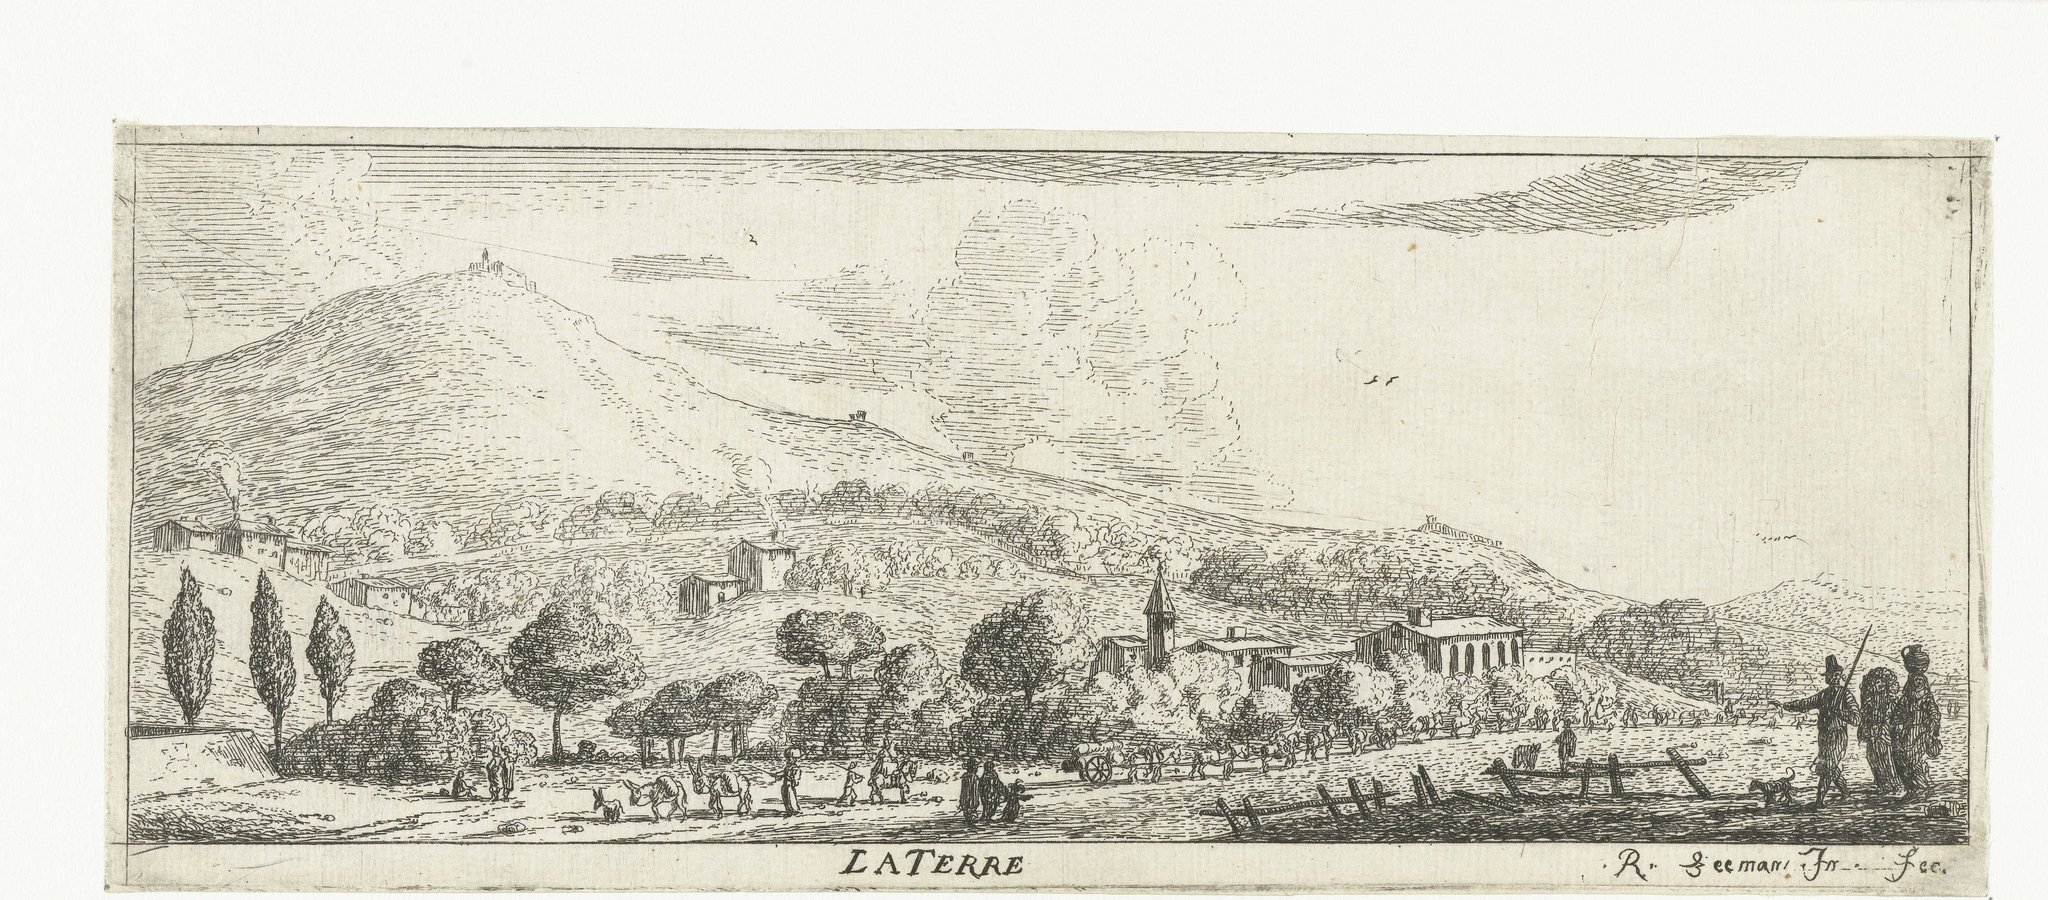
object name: print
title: Vier elementen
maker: reinier nooms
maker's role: draughtsman, painter, print maker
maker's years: 1623-1664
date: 1651-1652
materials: paper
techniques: etching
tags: earth (one of the four elements), (high) hill, village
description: Heuvellandschap met een klein dorp, wandelaars en een aantal karren getrokken door paarden.